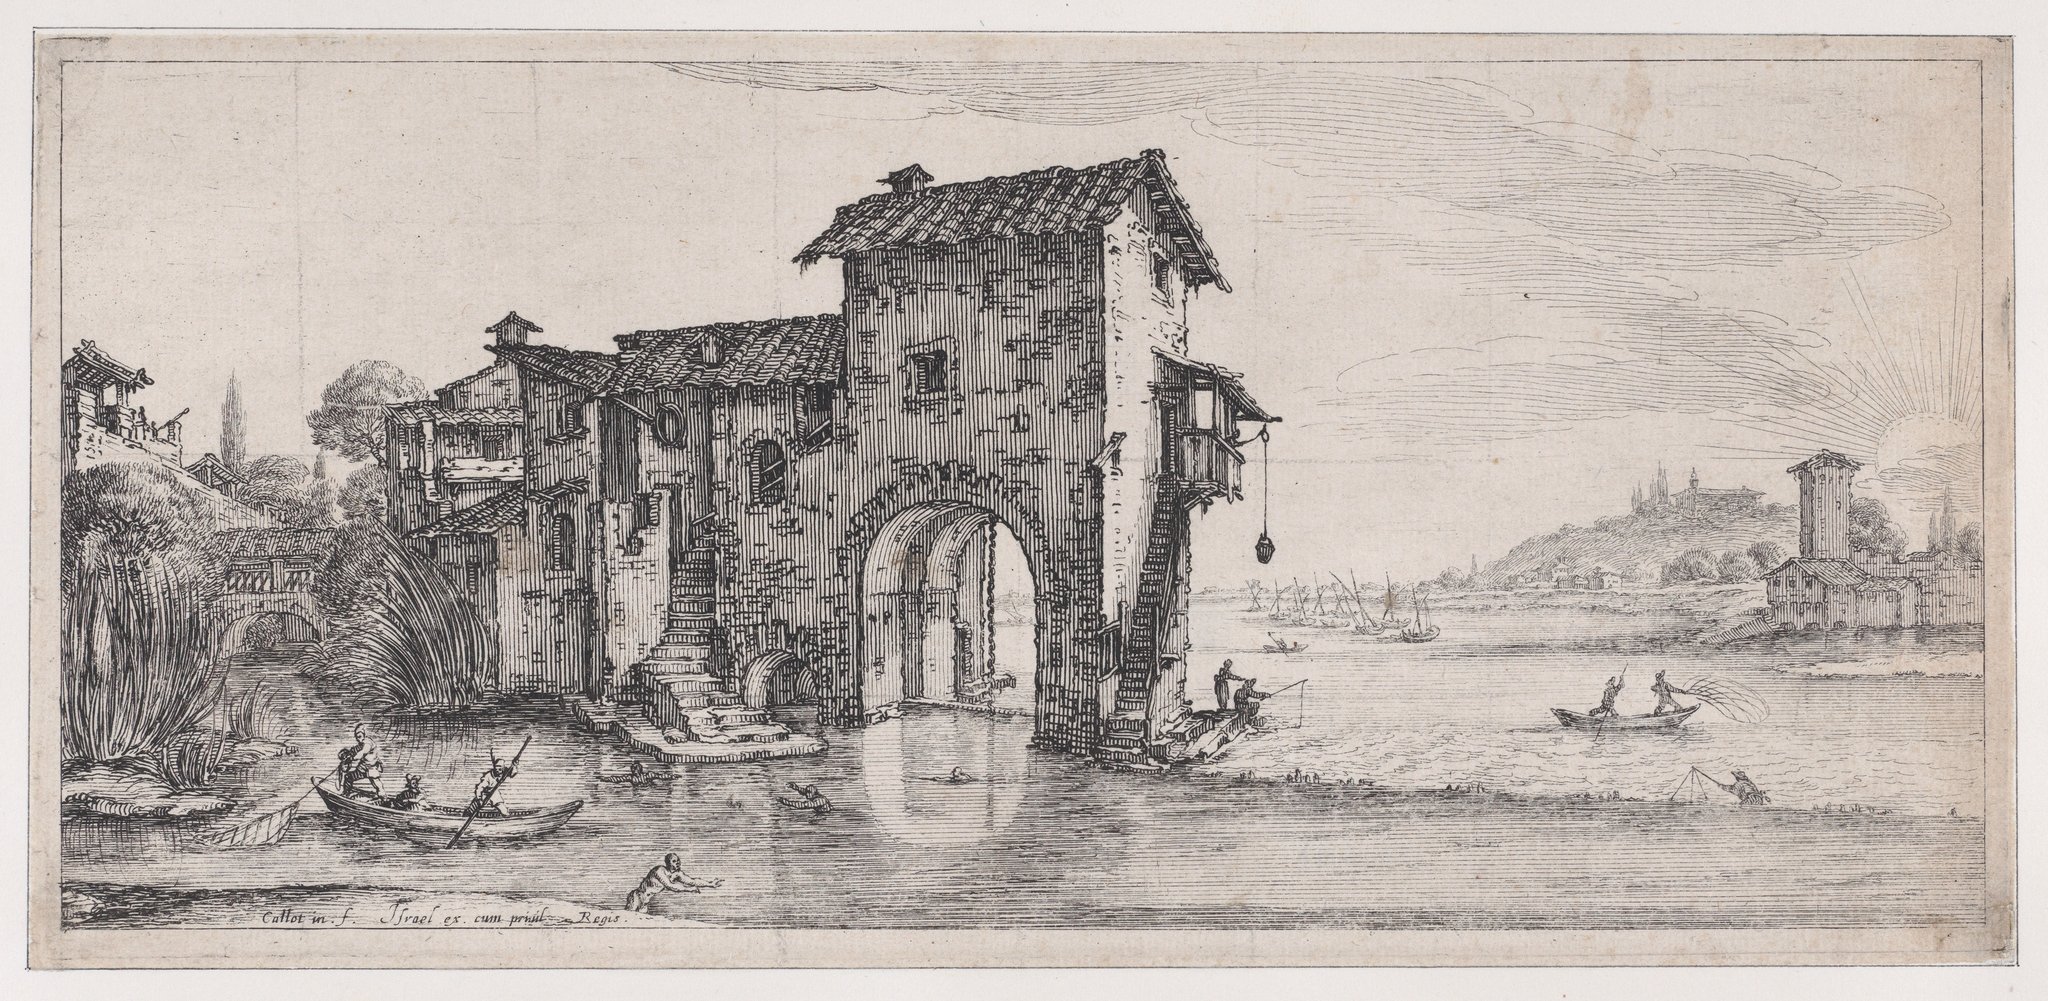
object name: print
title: Le Moulin a Eau (The Water Mill), from Paysages Gravés pour Jean de Médicis appelées aussi Paysages Dessinés a Florence, Vues de Florence, Paysages d'Italie, et Paysages Définitifs (Landscapes Engraved for Giovanni de'Medici, Landscapes Designed in Florence, Views of Florence, Landscapes of Italy, and Definitive Landscapes)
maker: jacques callot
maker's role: artist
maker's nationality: french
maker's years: 1592-1635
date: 1618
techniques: etching